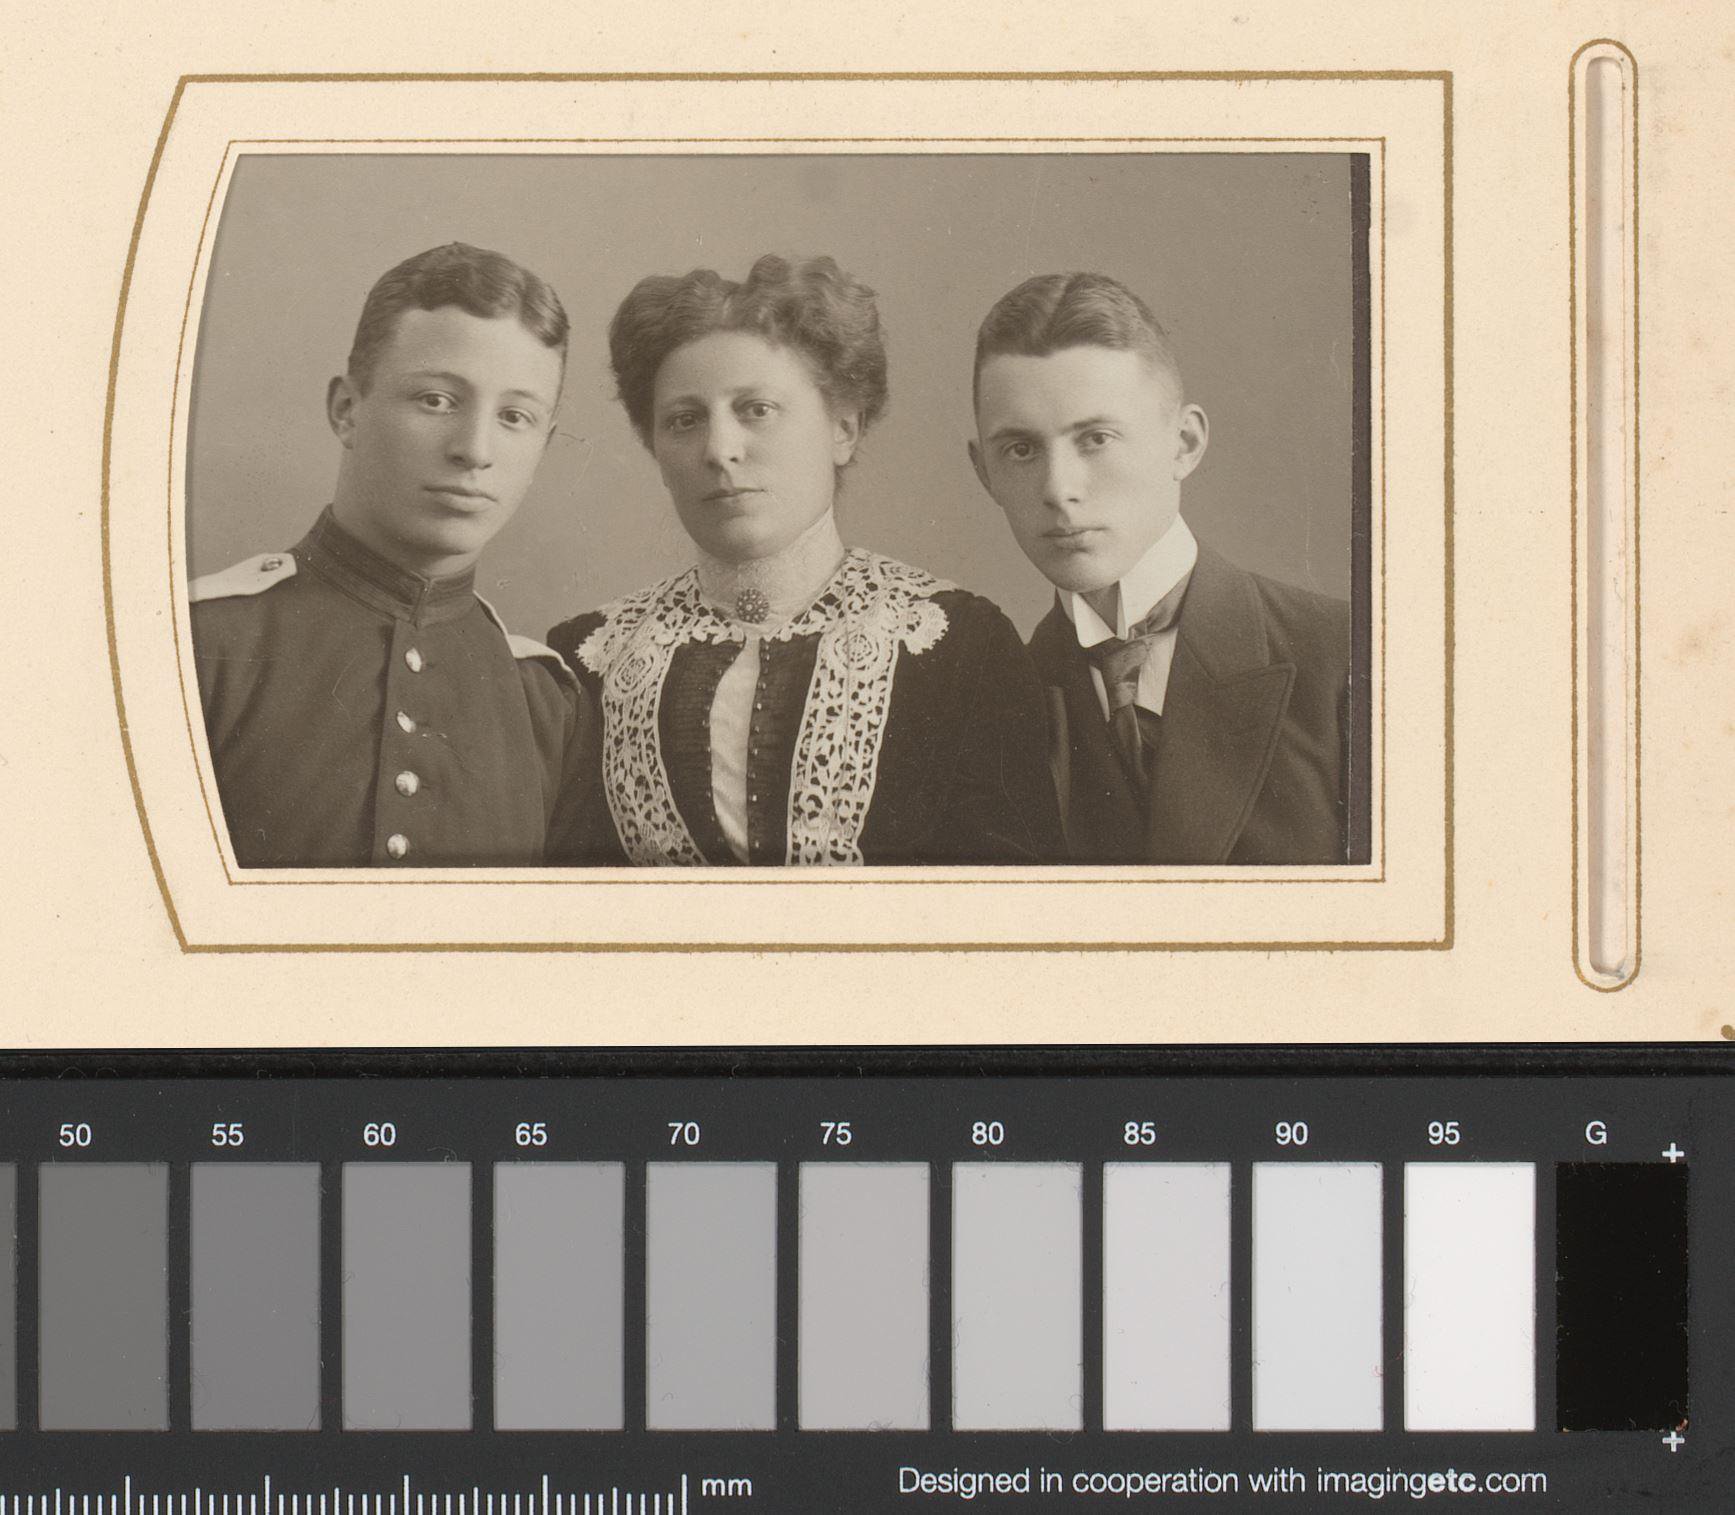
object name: carte de visite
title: Portret van twee mannen en een vrouw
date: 1895-1920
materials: cardboard, photographic support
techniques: matte daylight collodion silver print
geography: charlottenburg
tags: adult man (+ two persons), historical persons - bb - woman, historical persons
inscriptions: annotation: ‘Hedweig Sch[ät]ze/ mit [...], [...], [...]’, number: ‘6380’, inscription: ‘ATELIER/ KAUFHAUS/ desWESTeNS/ G.M.B.H. BERLIN/ Platten bleiben/ aufbewahrt./ Vergösserun-/ gen nach jedem/ bilde.’